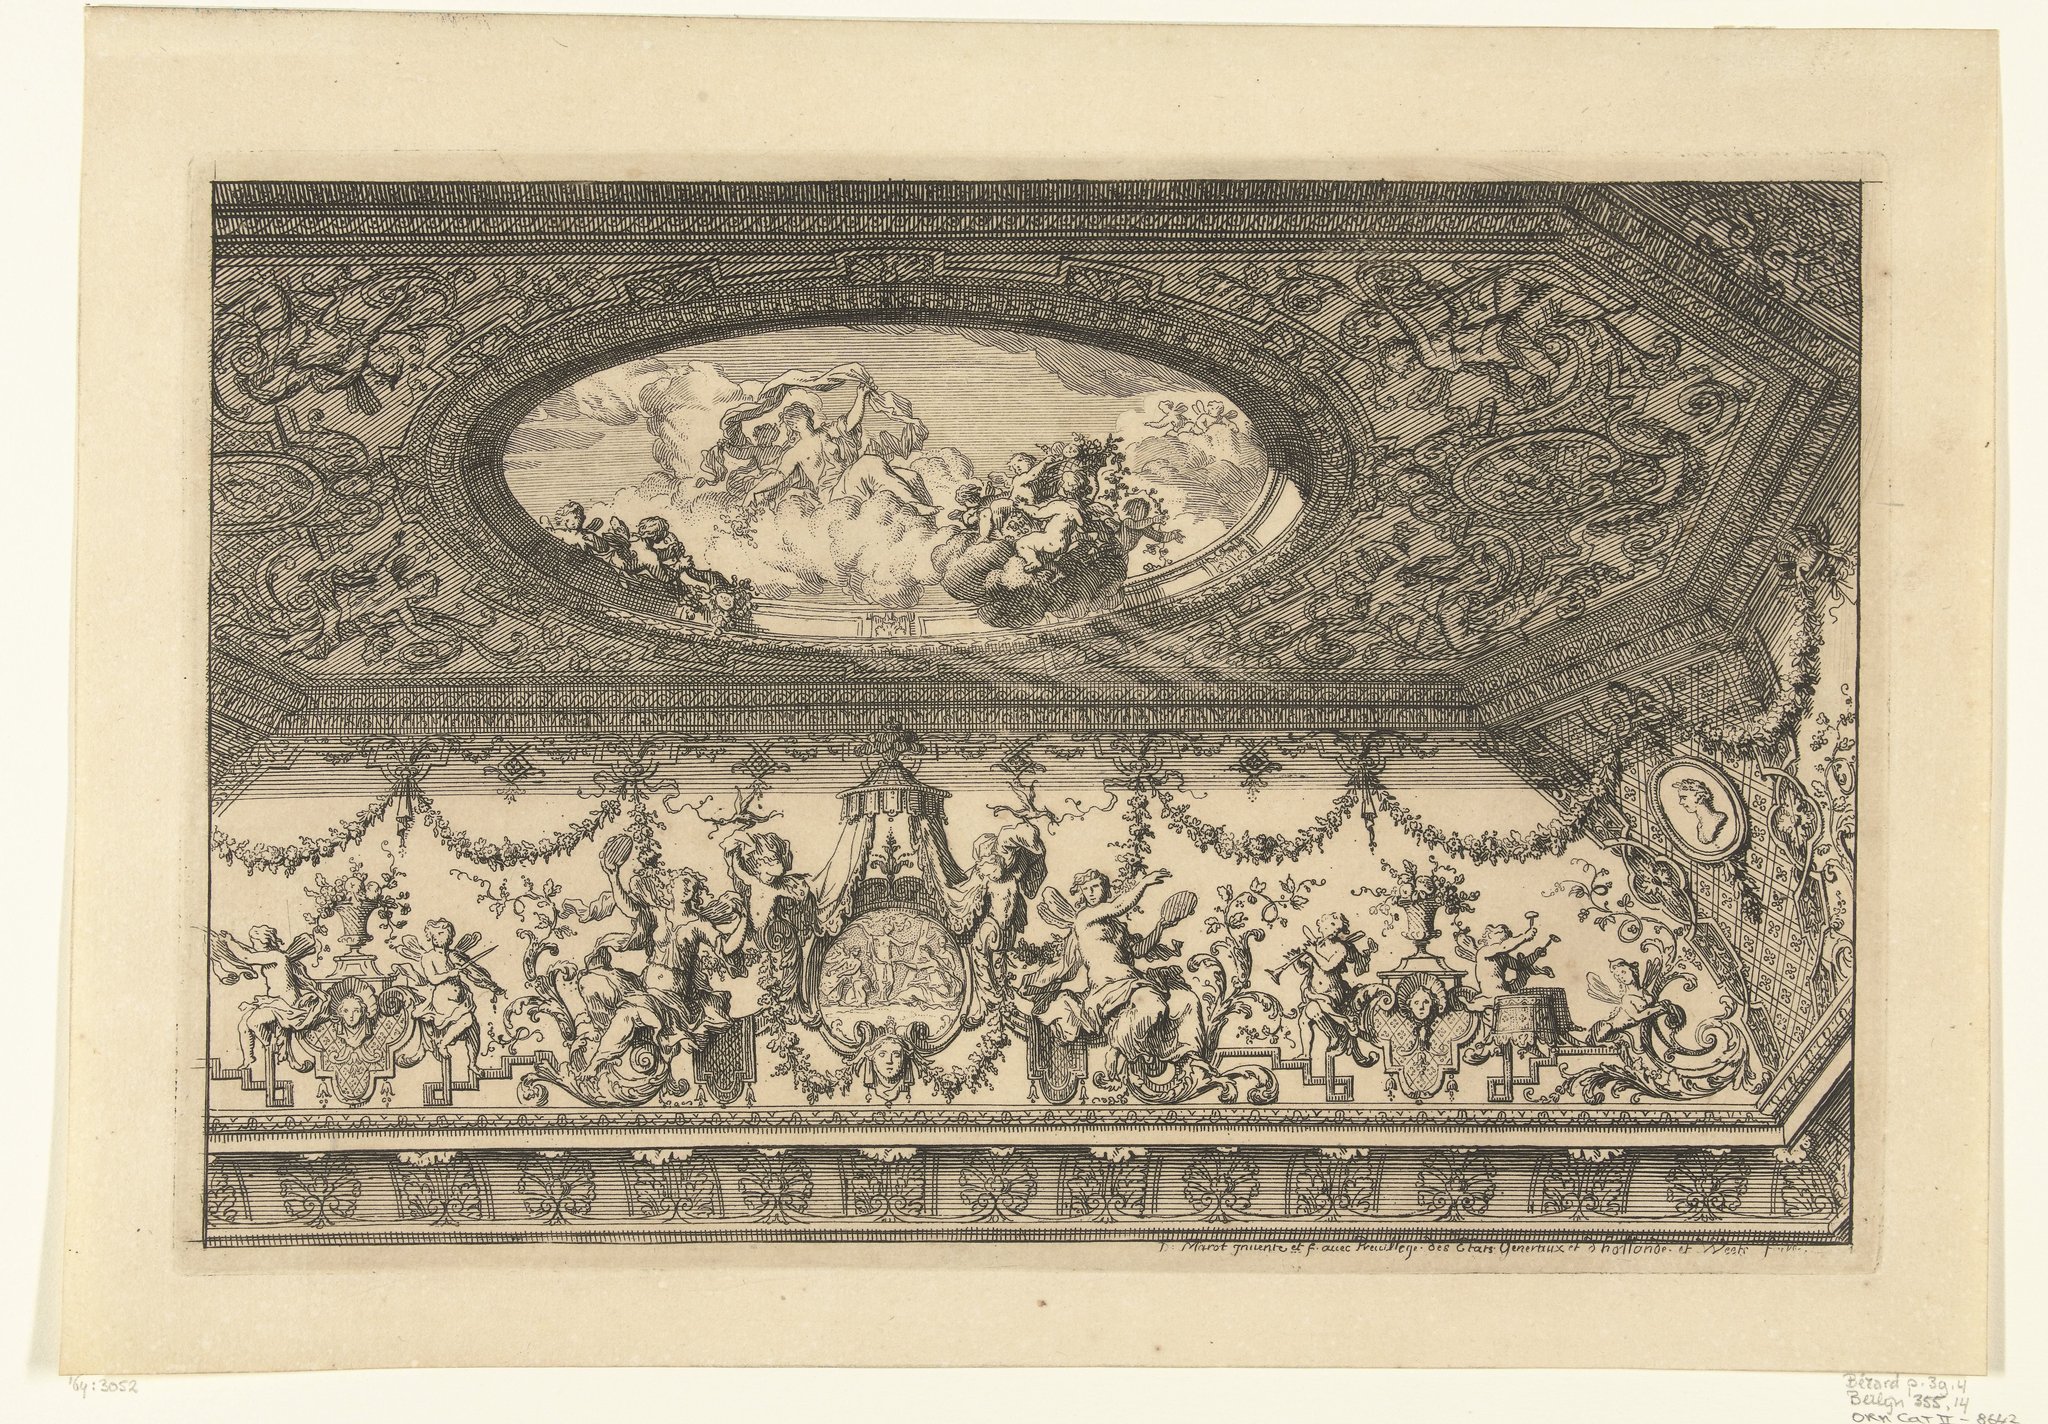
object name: print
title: Nouveau Liure de Placfond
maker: daniël marot (i)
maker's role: draughtsman, print maker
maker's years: 1661-1752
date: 1712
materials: paper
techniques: etching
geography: netherlands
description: In het midden is een medaillon onder een baldakijn afgebeeld. Uit serie van 6 bladen met ontwerpen voor plafonds.